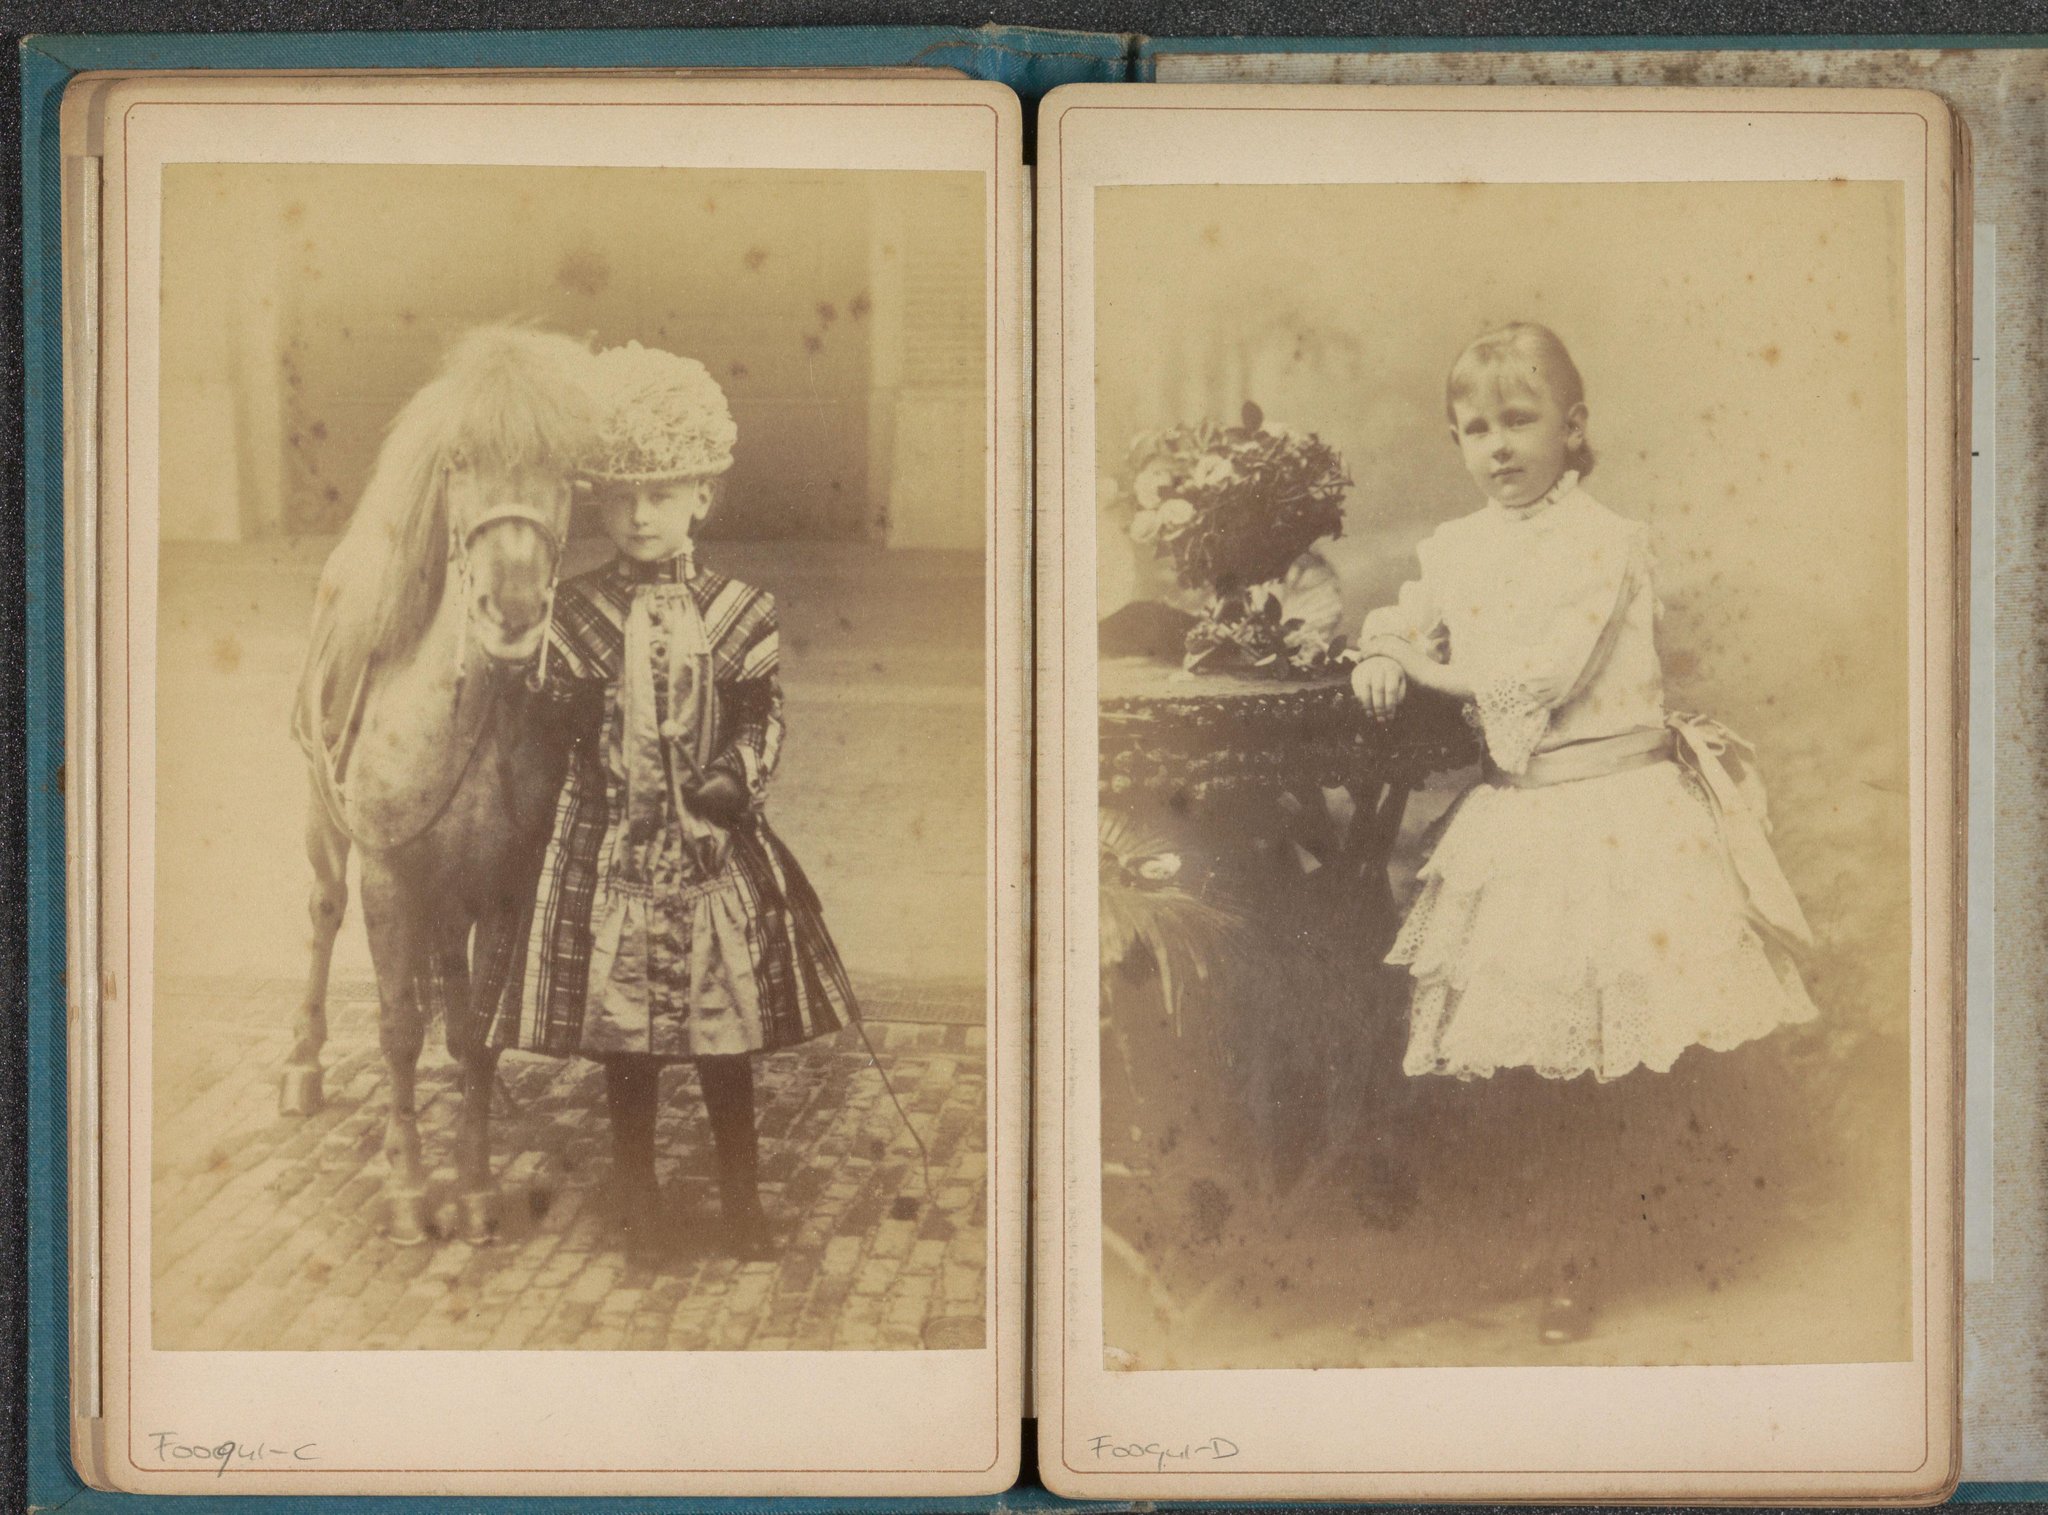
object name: cabinet photograph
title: Portret van prinses Wilhelmina als meisje, staand bij een tafel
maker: Anonymous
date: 1886-1888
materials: cardboard, photographic support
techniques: albumen print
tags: the hague, wilhelmina of the netherlands, child, ruler, sovereign - bb - female ruler, table, netherlands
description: Onderdeel van Fotoalbum met opnames van prinses Wilhelmina als kind tot aan haar inhuldiging in 1898.